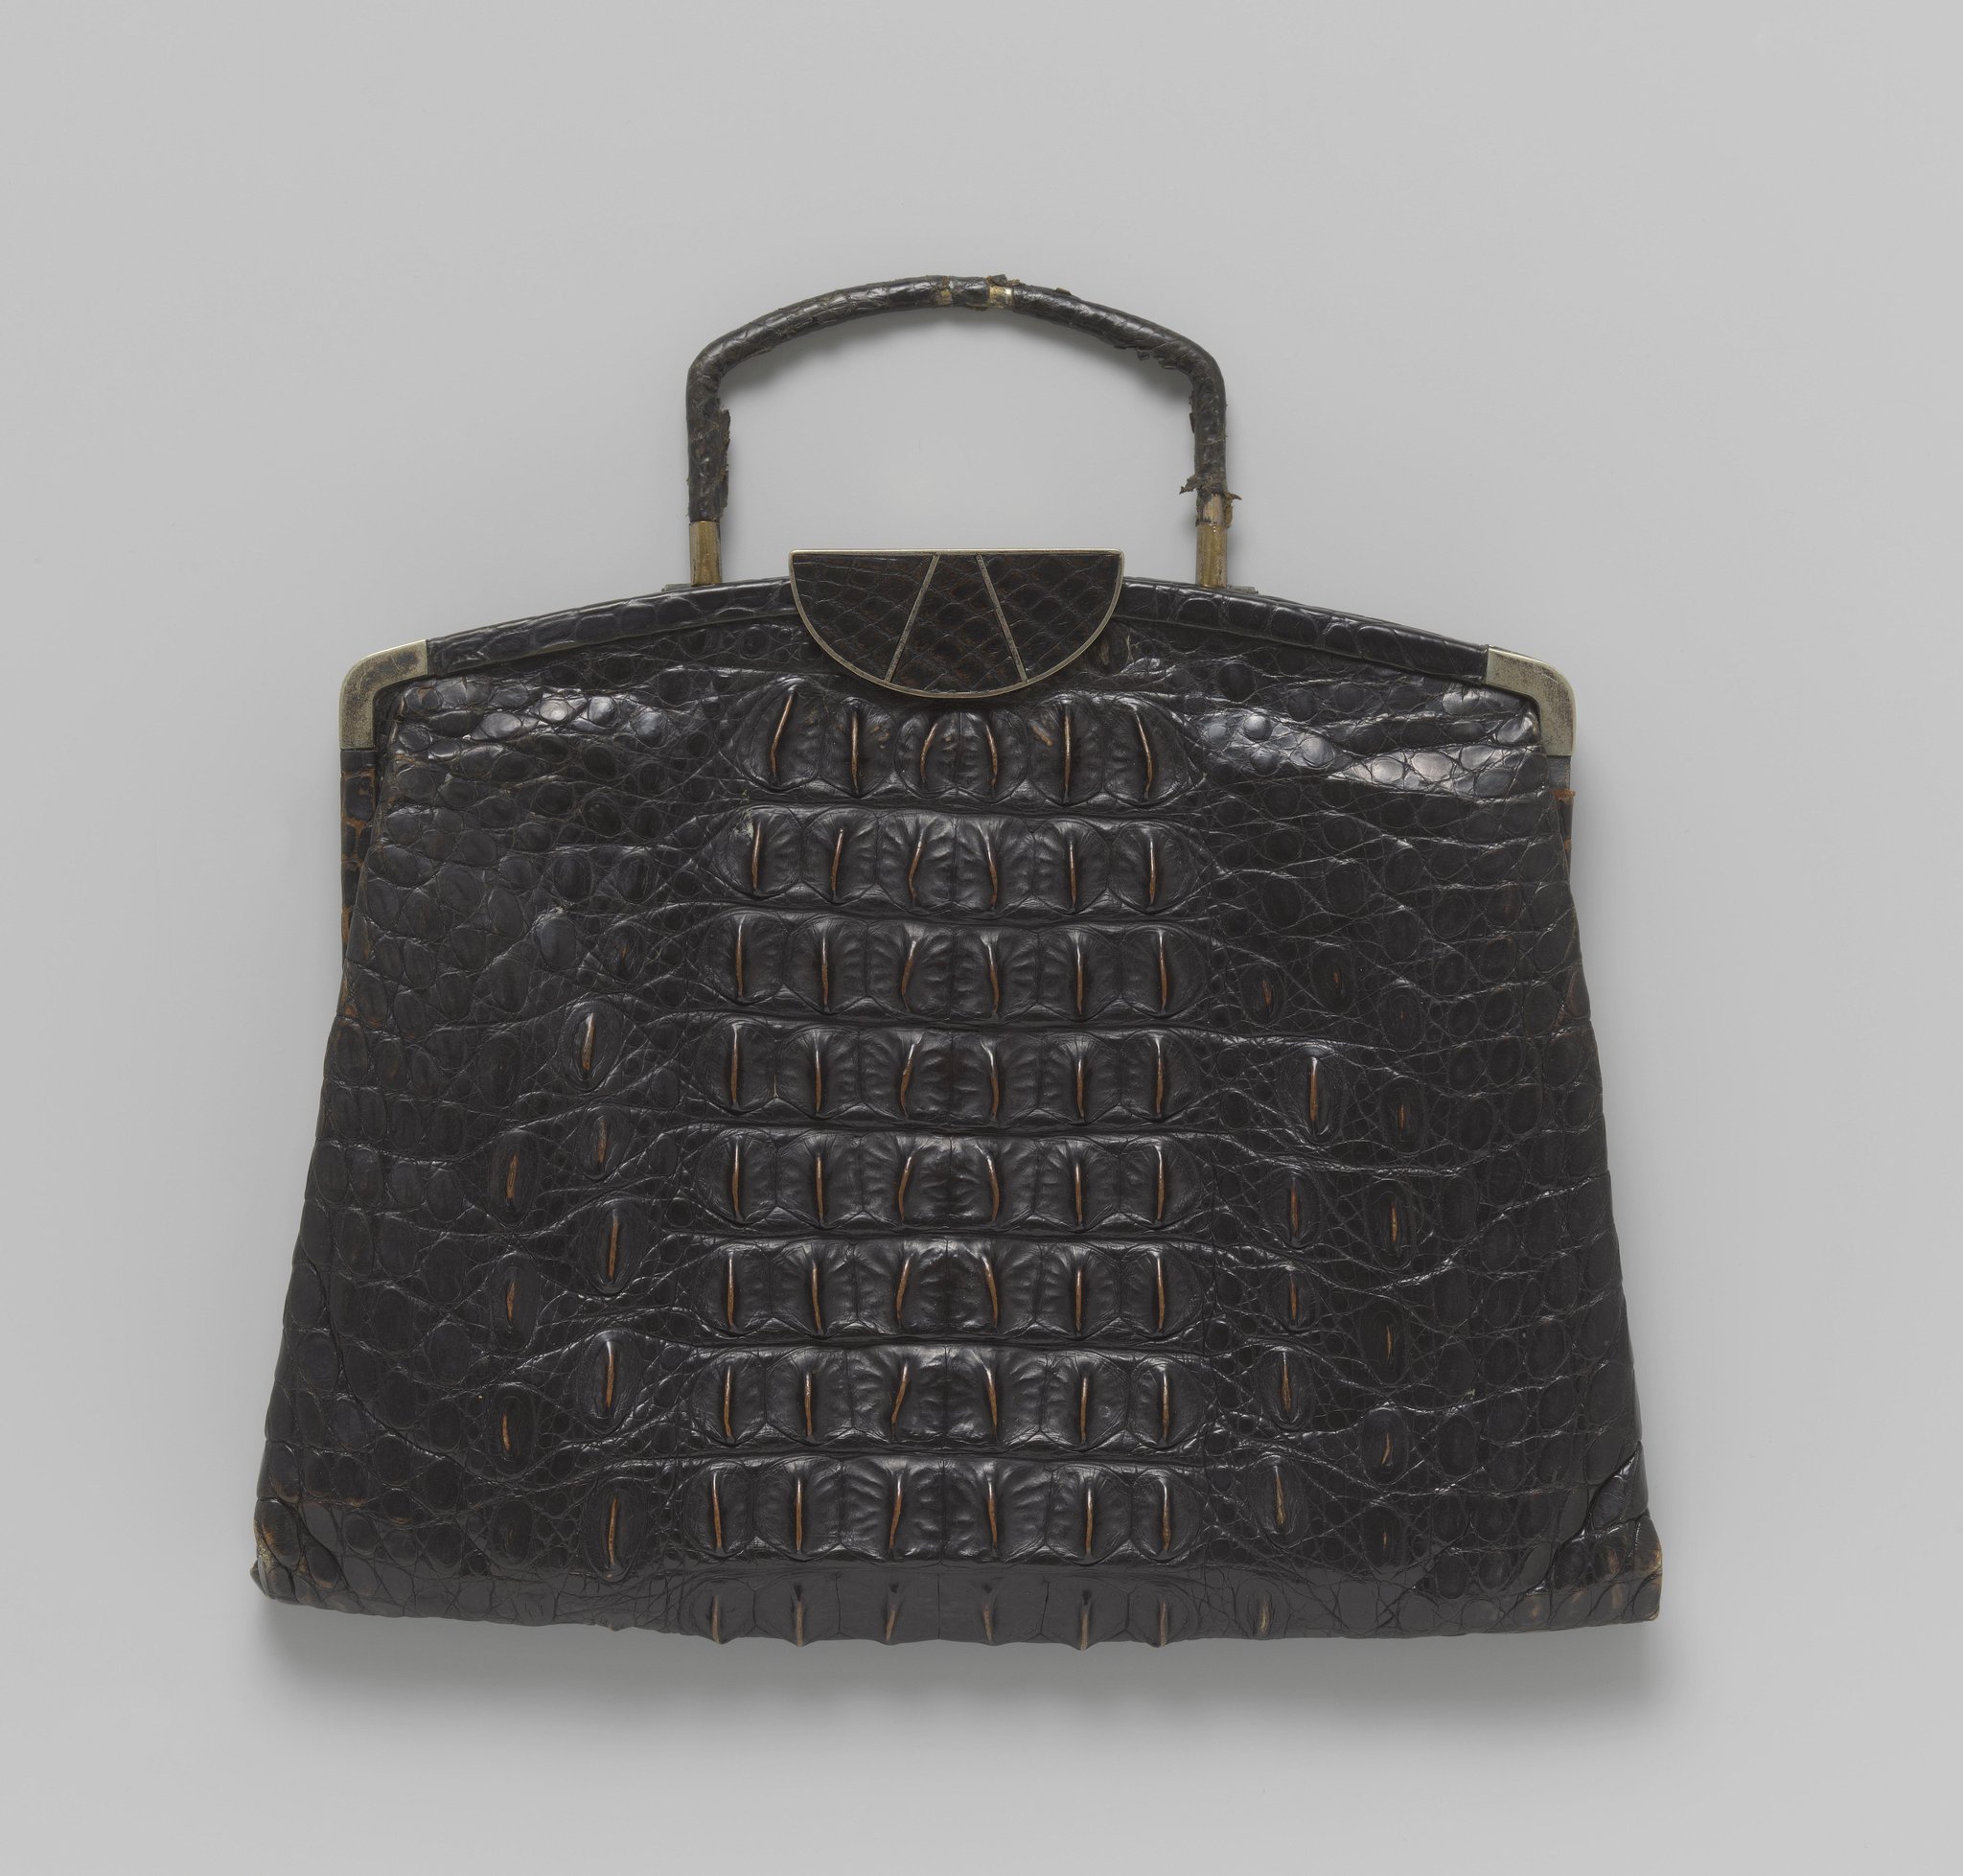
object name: beugeltas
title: Beugeltas van donkerbruin reptielenleer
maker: Anonymous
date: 1910-1940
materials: leather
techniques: lining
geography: europe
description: De tas sluit met een gesp, heeft een handvat en is van binnen met beige suède gevoerd.